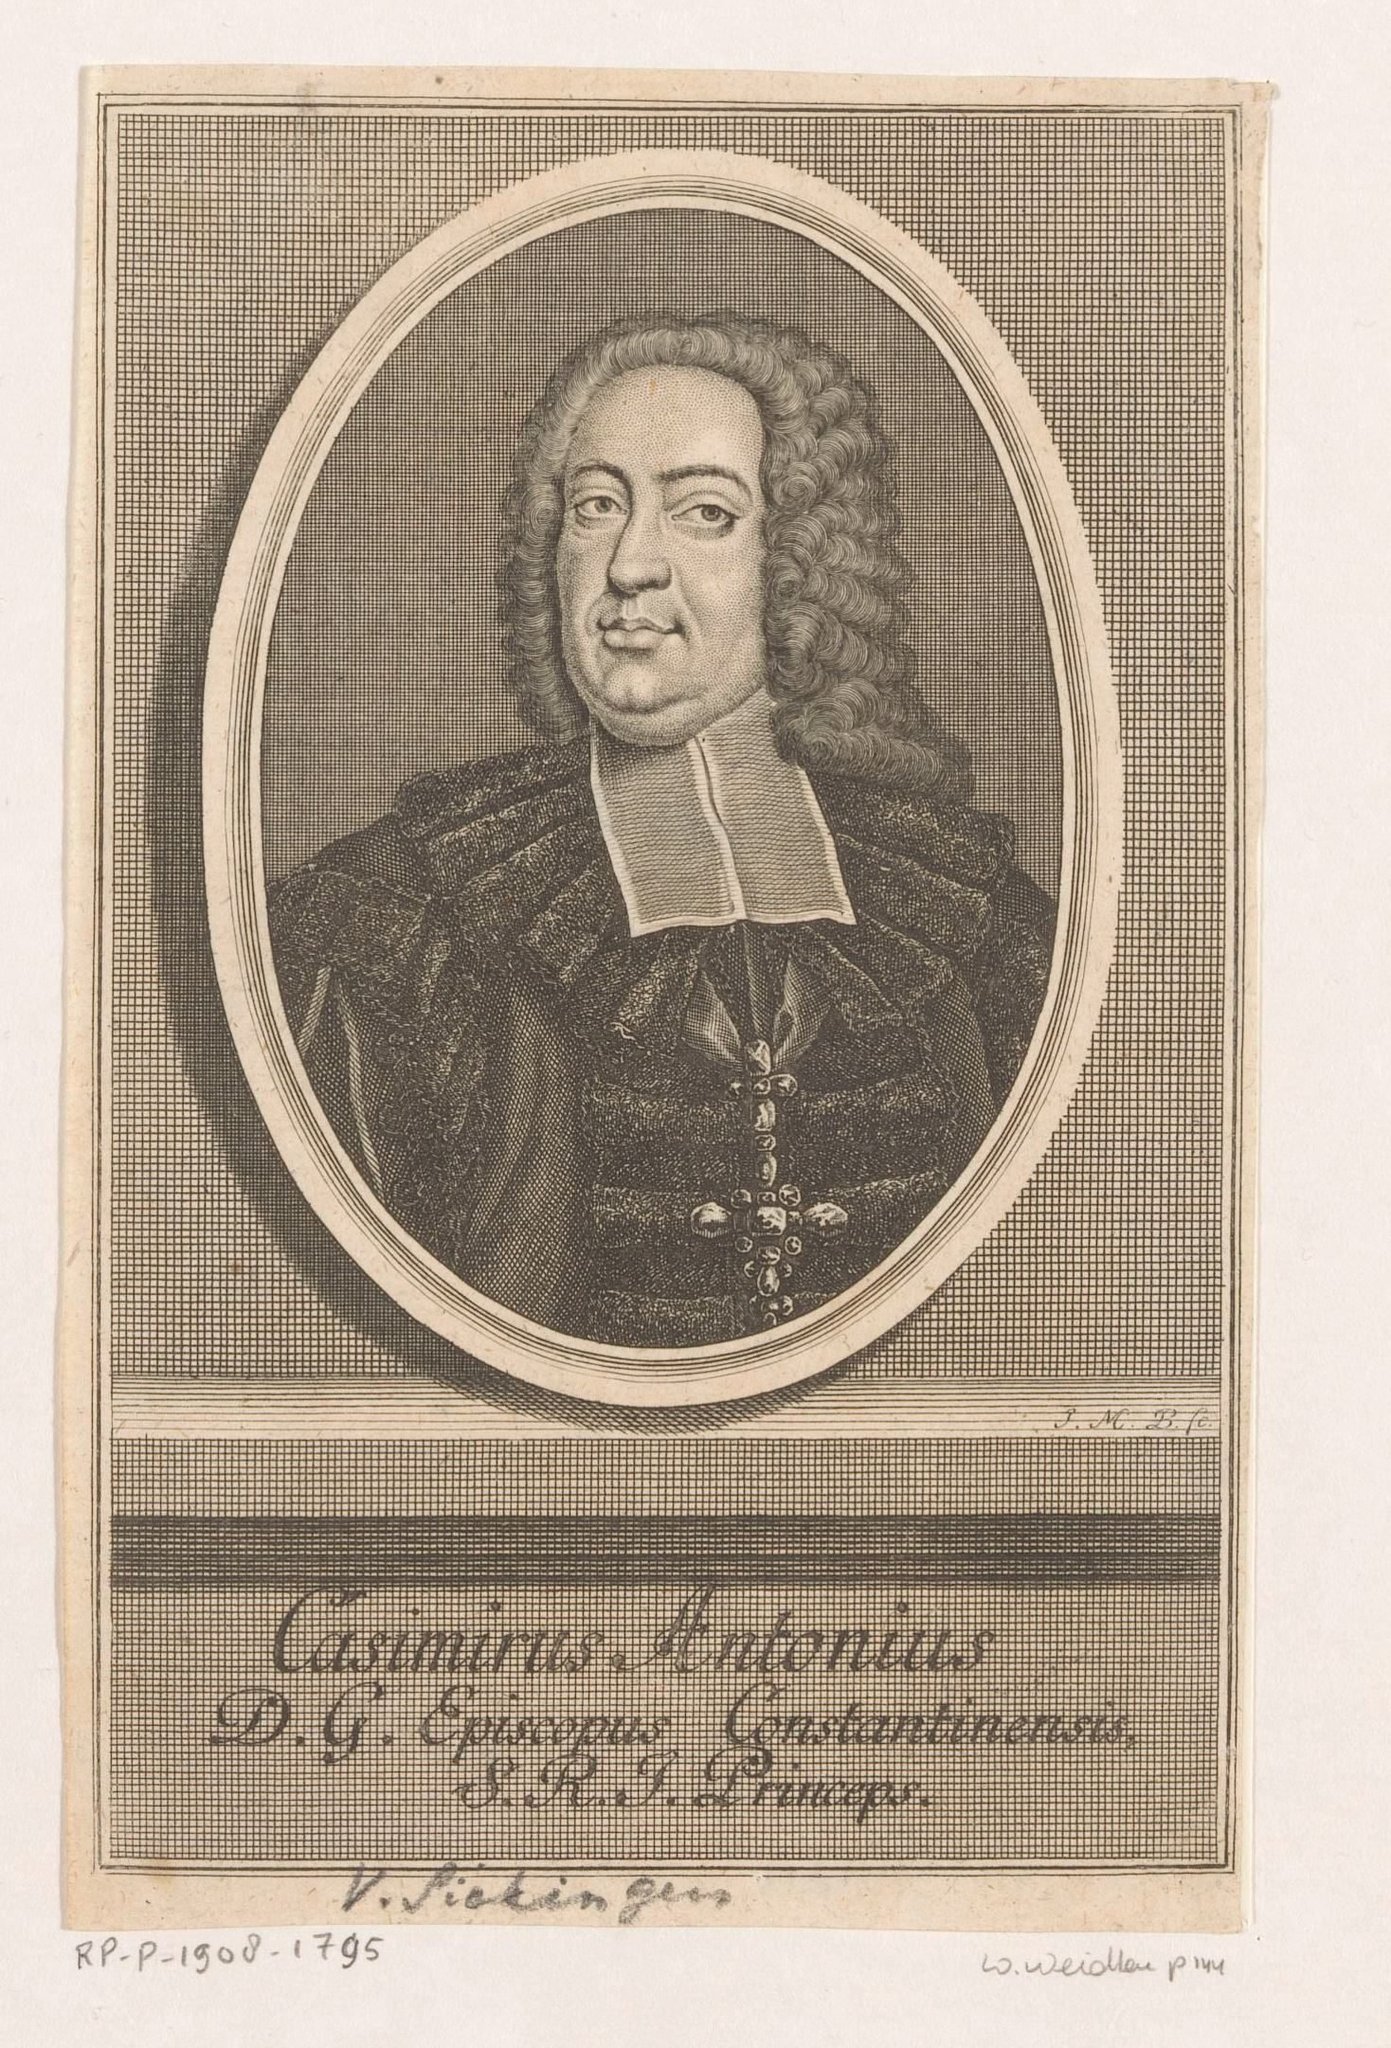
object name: print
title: Portret van Casimir Anton, Reichsfreiherr von Sickingen, bisschop van Konstanz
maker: johann martin bernigeroth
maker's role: print maker, publisher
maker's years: 1713-1767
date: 1744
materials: paper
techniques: engraving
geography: leipzig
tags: historical persons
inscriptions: collector's mark: Lugt 2228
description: Prent ook gebruikt in: Die Neue Europäische Fama, Welche den gegenwärtigen Zustand der vornehmsten Höfe entdecket. dl. 108. Leipzig: Gleditsch, 1744.